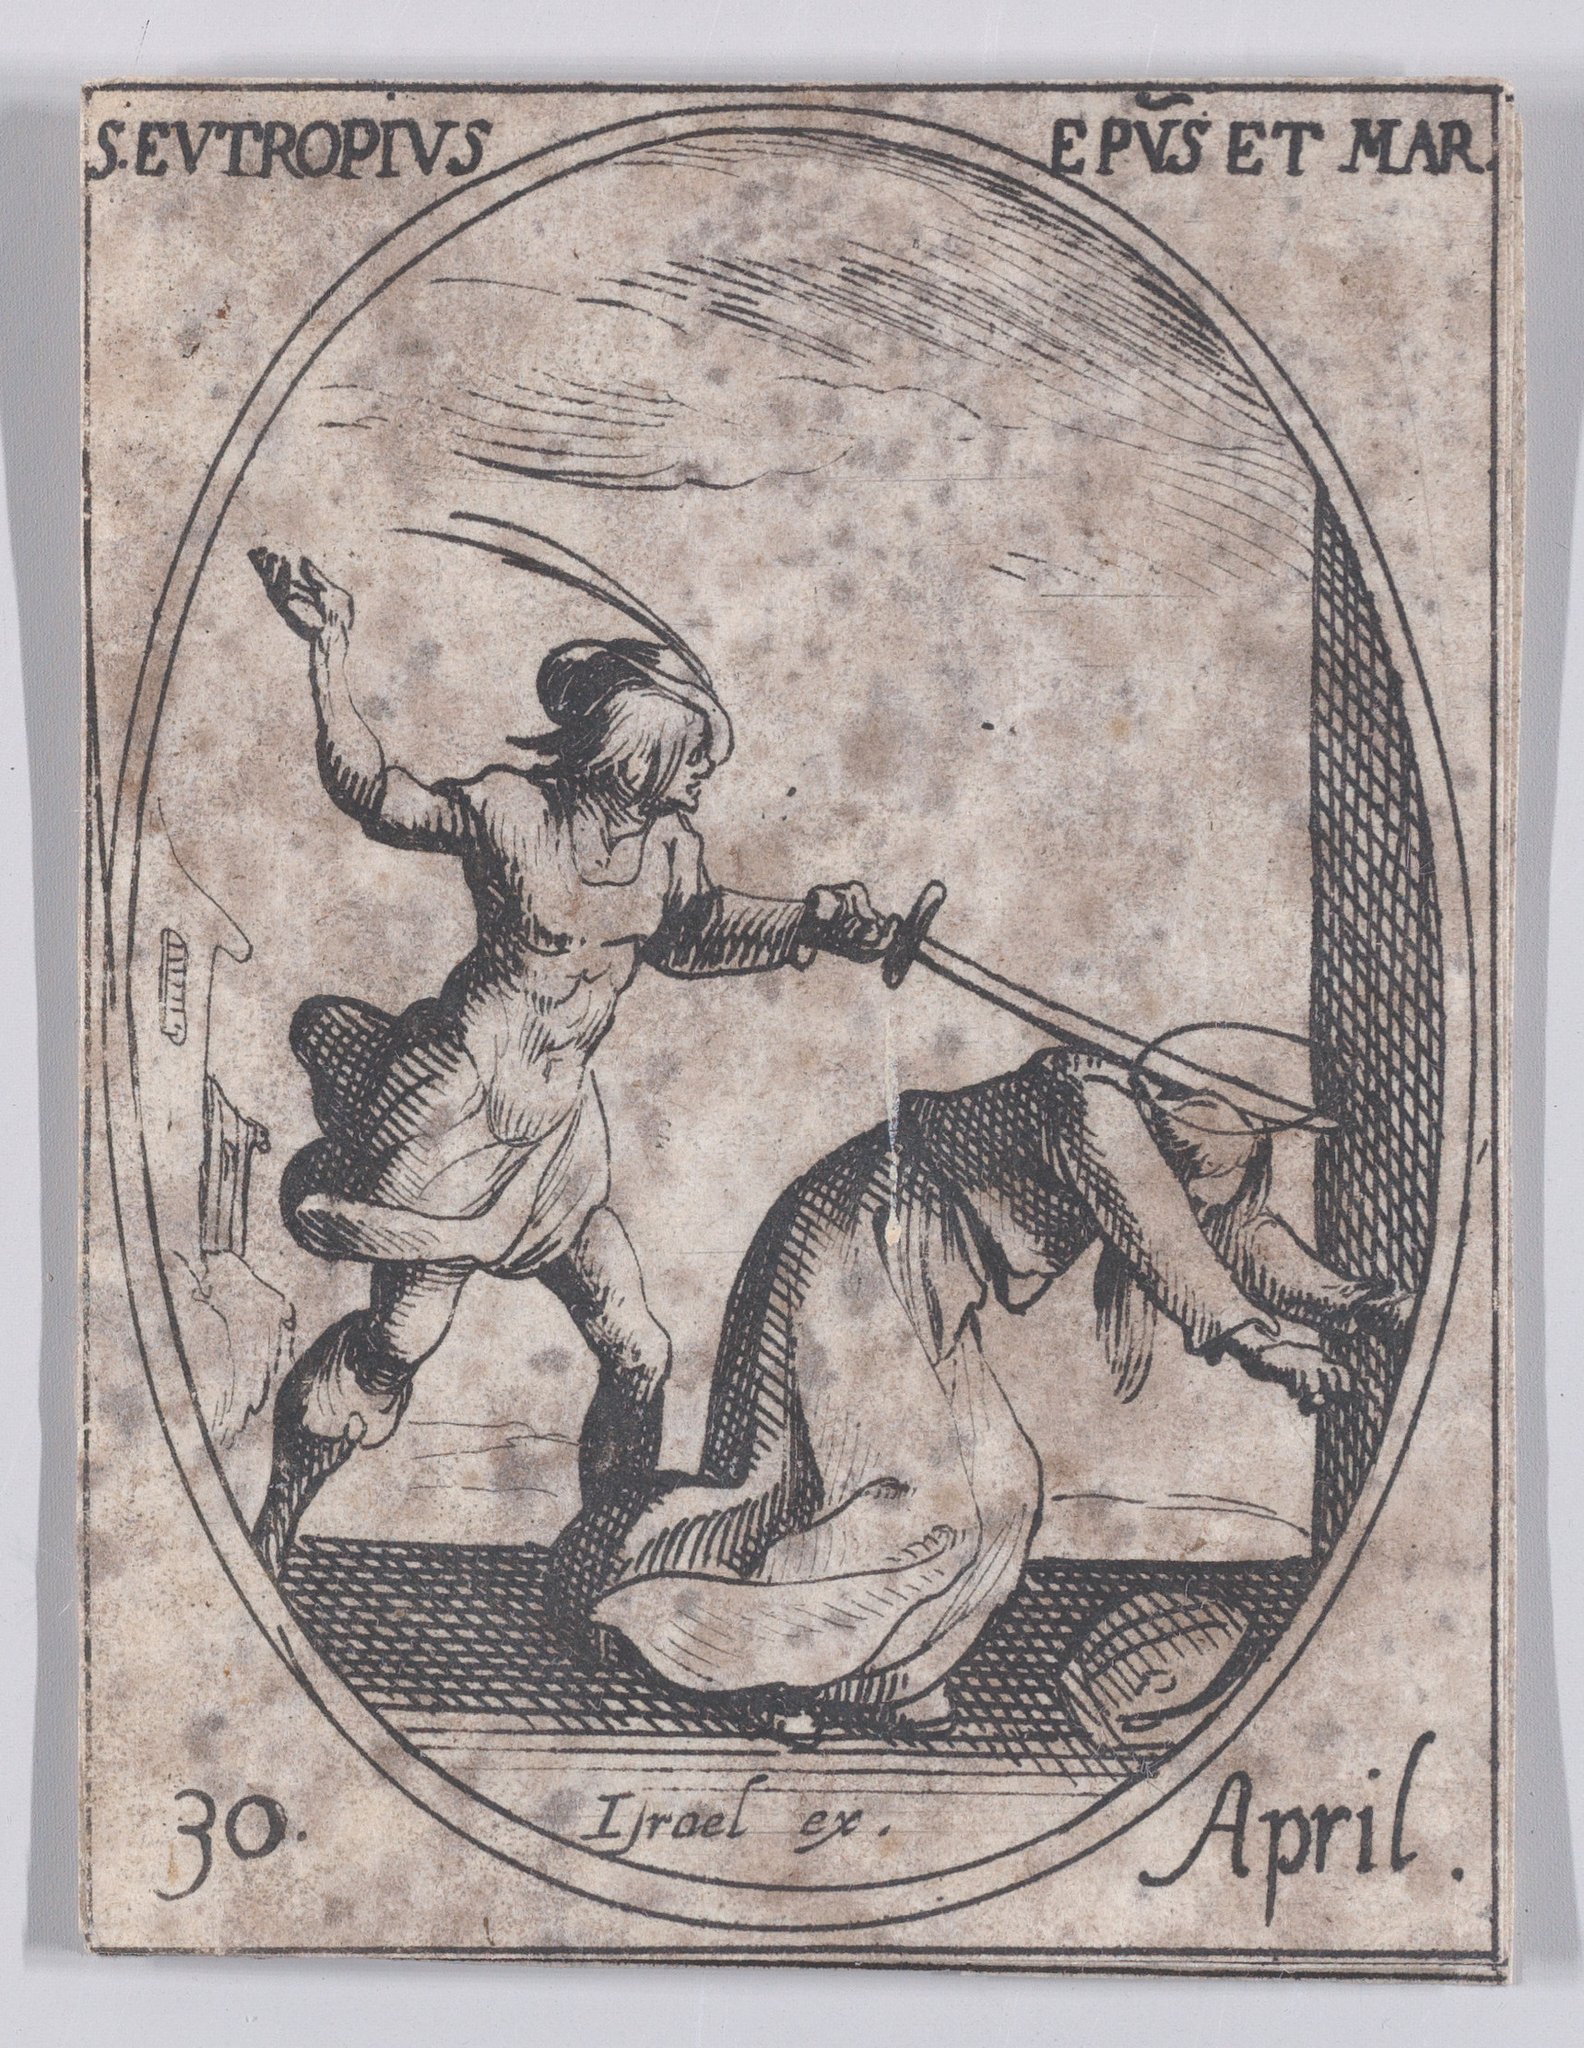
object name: print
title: S. Eutrope, évêque et martyr (St. Eutropius, Bishop and Martyr), April 30th, from "Les Images De Tous Les Saincts et Saintes de L'Année" (Images of All of the Saints and Religious Events of the Year)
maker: jacques callot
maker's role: artist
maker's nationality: french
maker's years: 1592-1635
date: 1636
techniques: etching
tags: men,saints